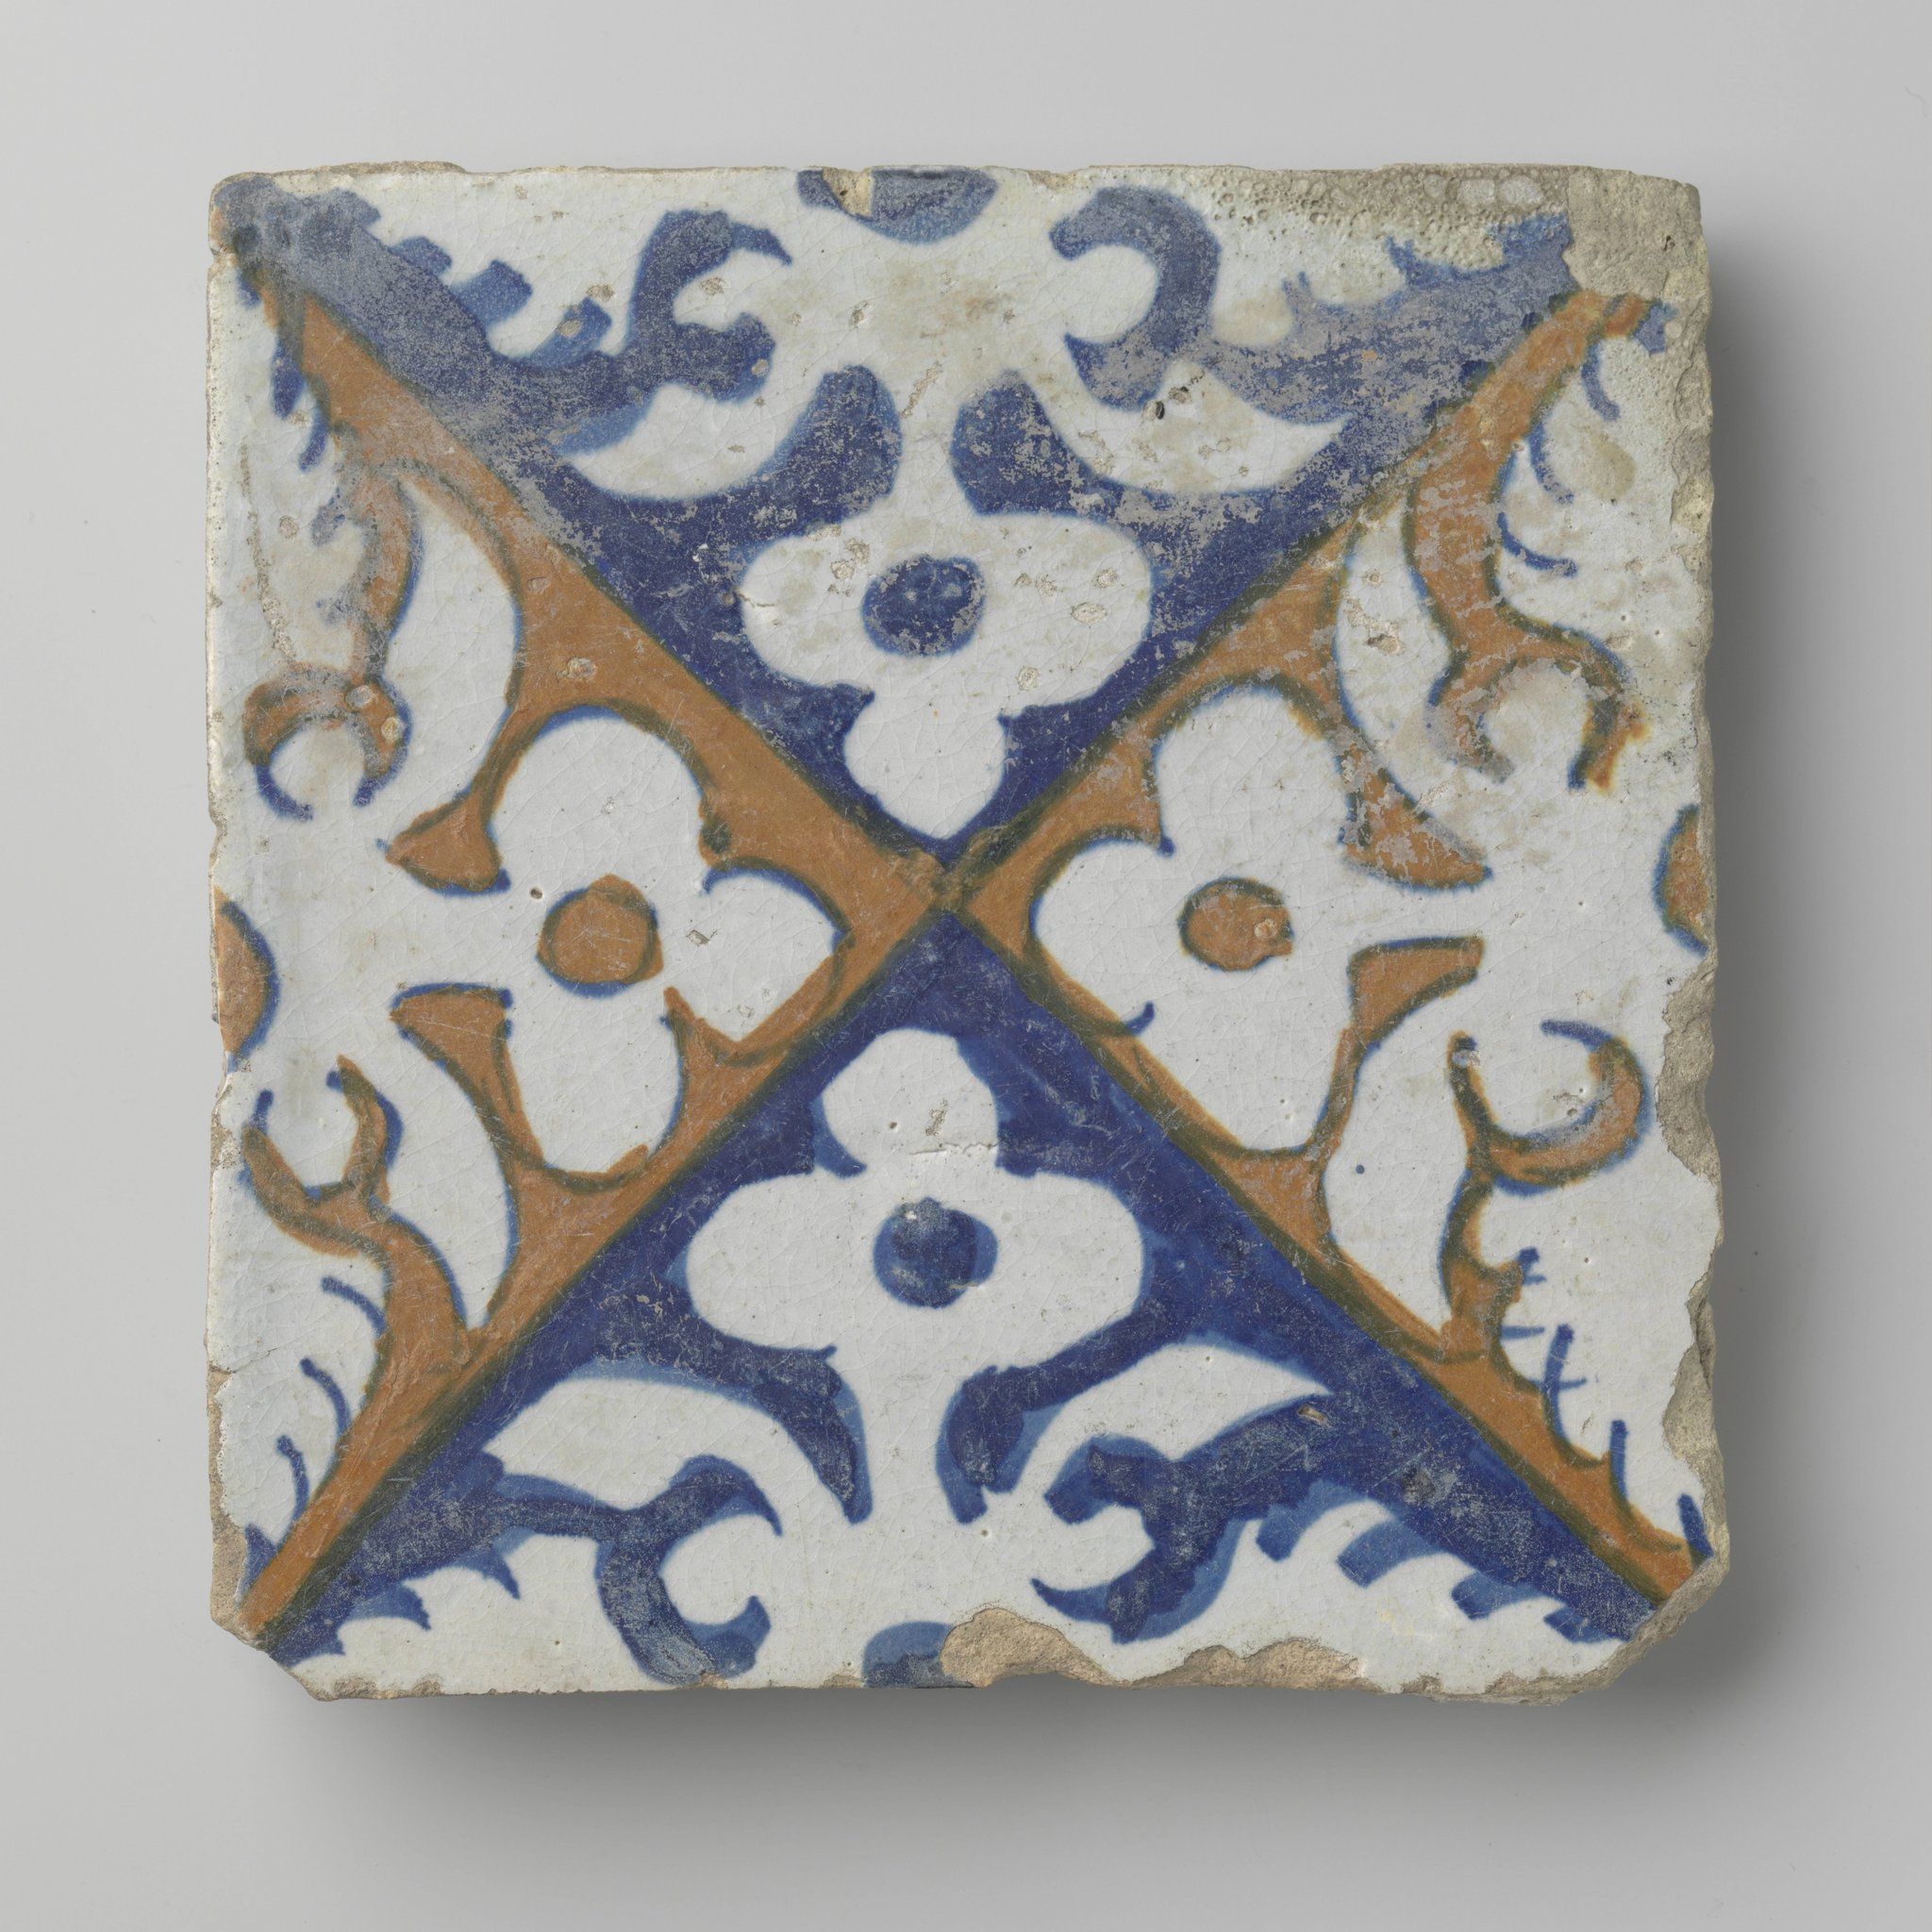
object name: tile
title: Tegel met bladpatronen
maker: Anonymous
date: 1560-1600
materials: earthenware, glaze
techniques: maiolica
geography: netherlands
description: Tegel met veelkleurig (blauw en oranje) geschilderde bladpatronen in vultechniek, in de vorm van vier gelijkzijdige driehoeken waarvan de toppen in het midden samenkomen.